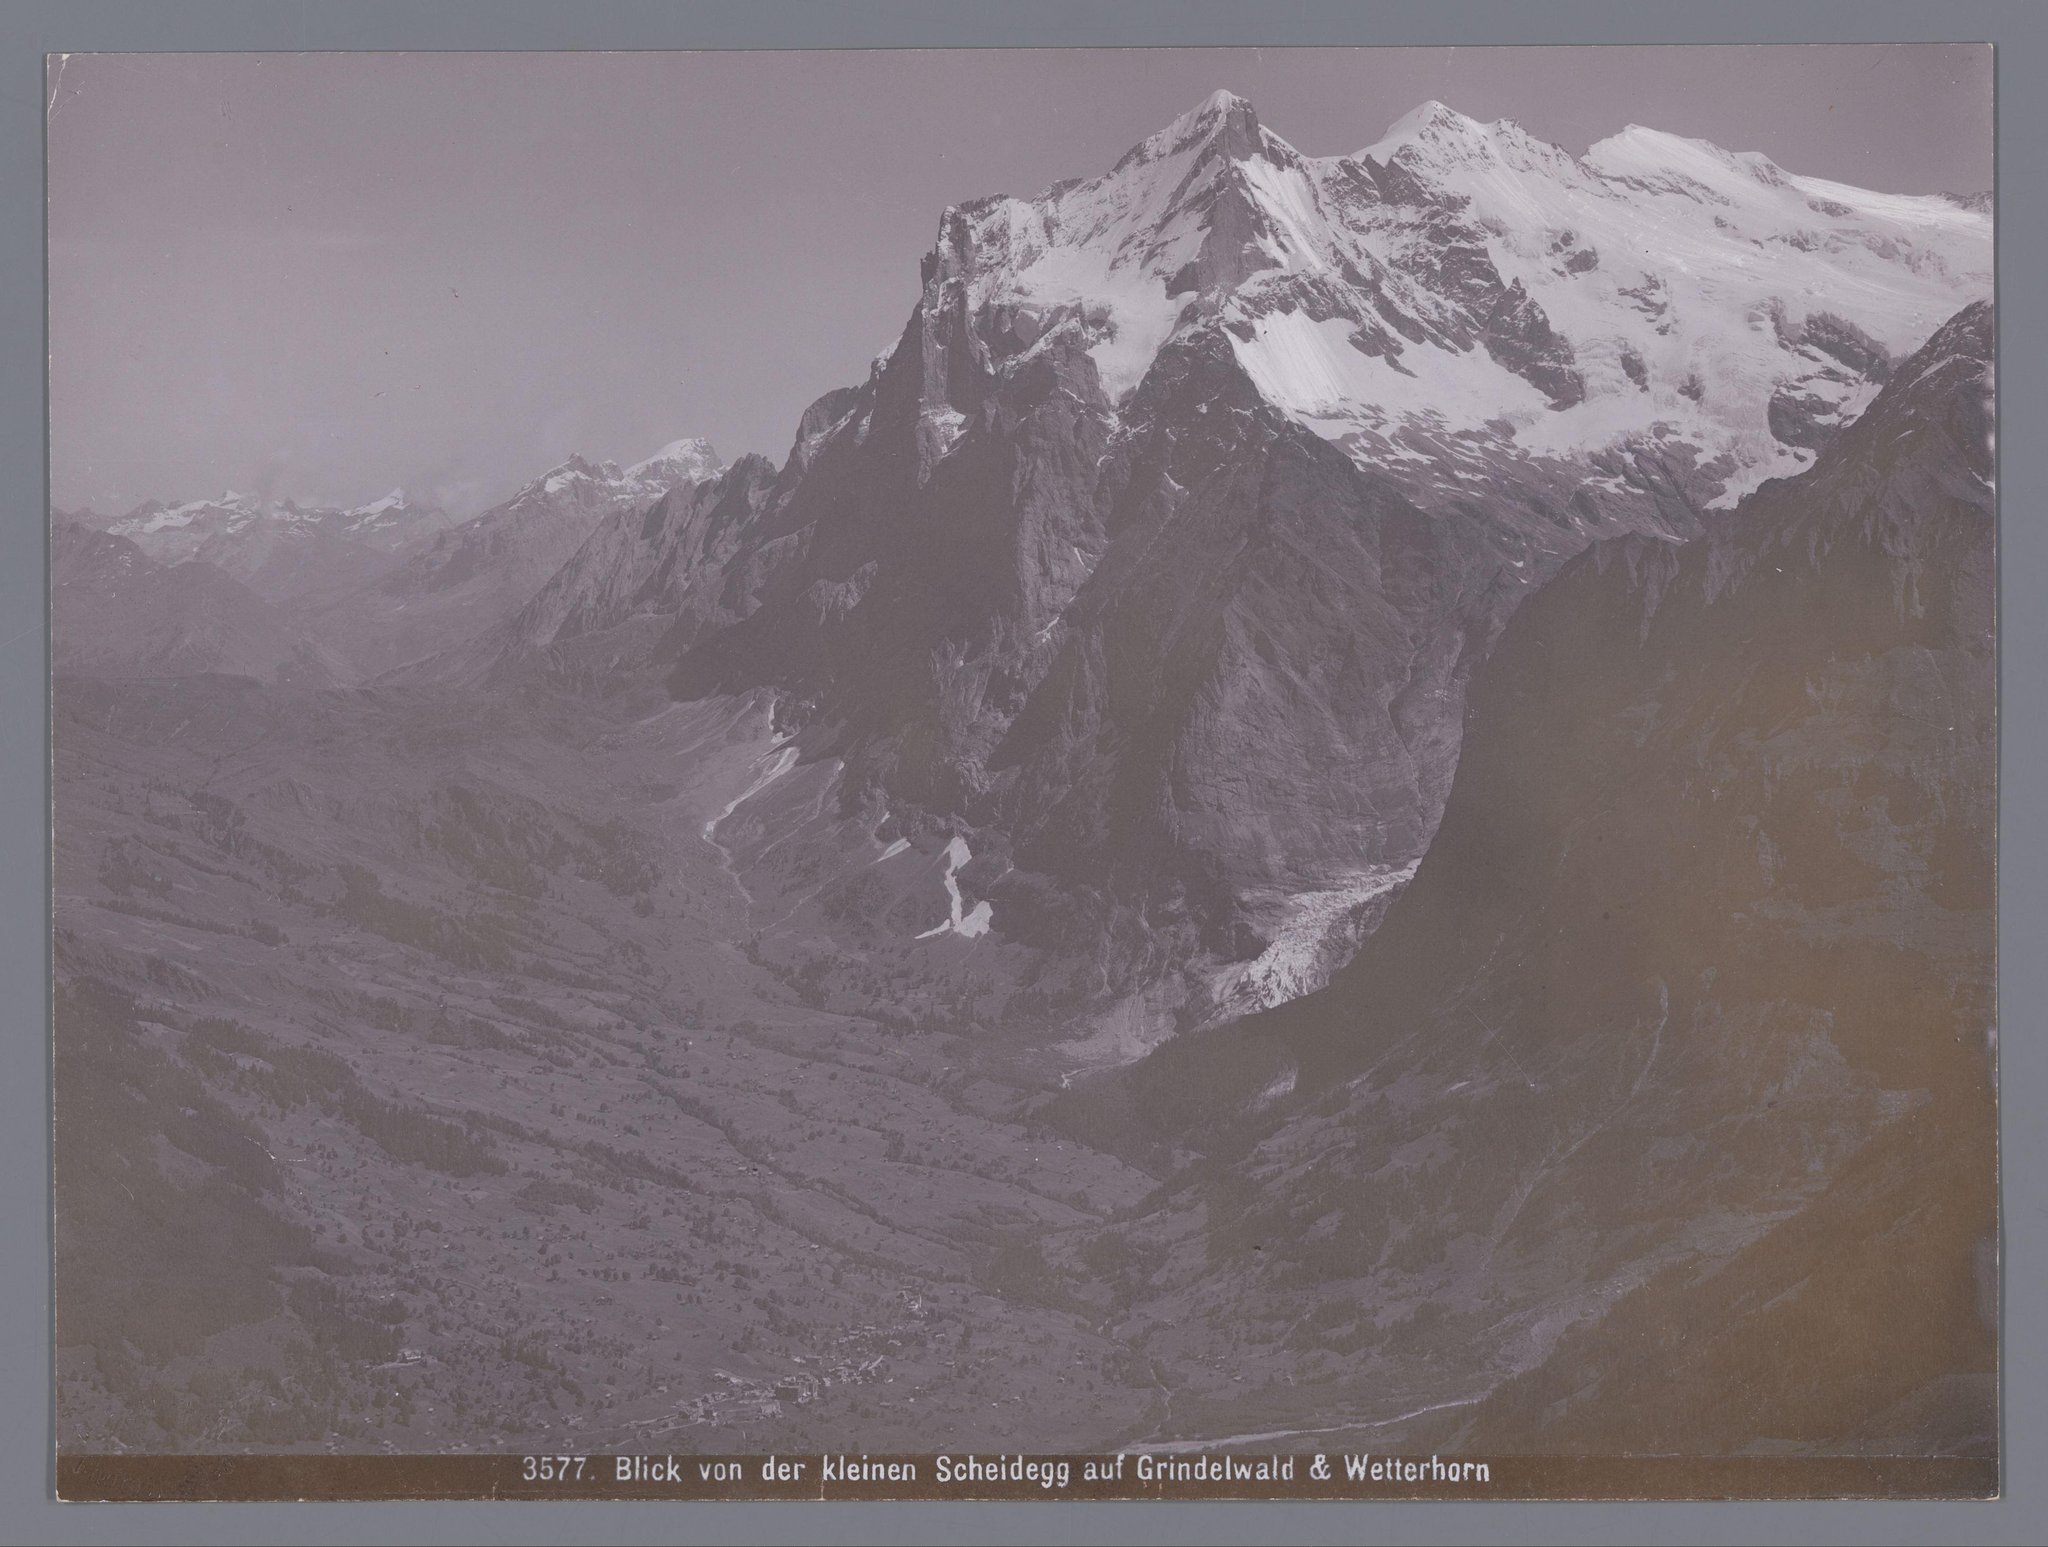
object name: photograph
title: Gezicht op de Grindelwald en de Wetterhorn vanaf de Kleine Scheidegg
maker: Anonymous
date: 1890-1930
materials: paper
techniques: gelatin silver print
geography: kleine Scheidegg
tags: mountains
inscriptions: number: ‘3577.’